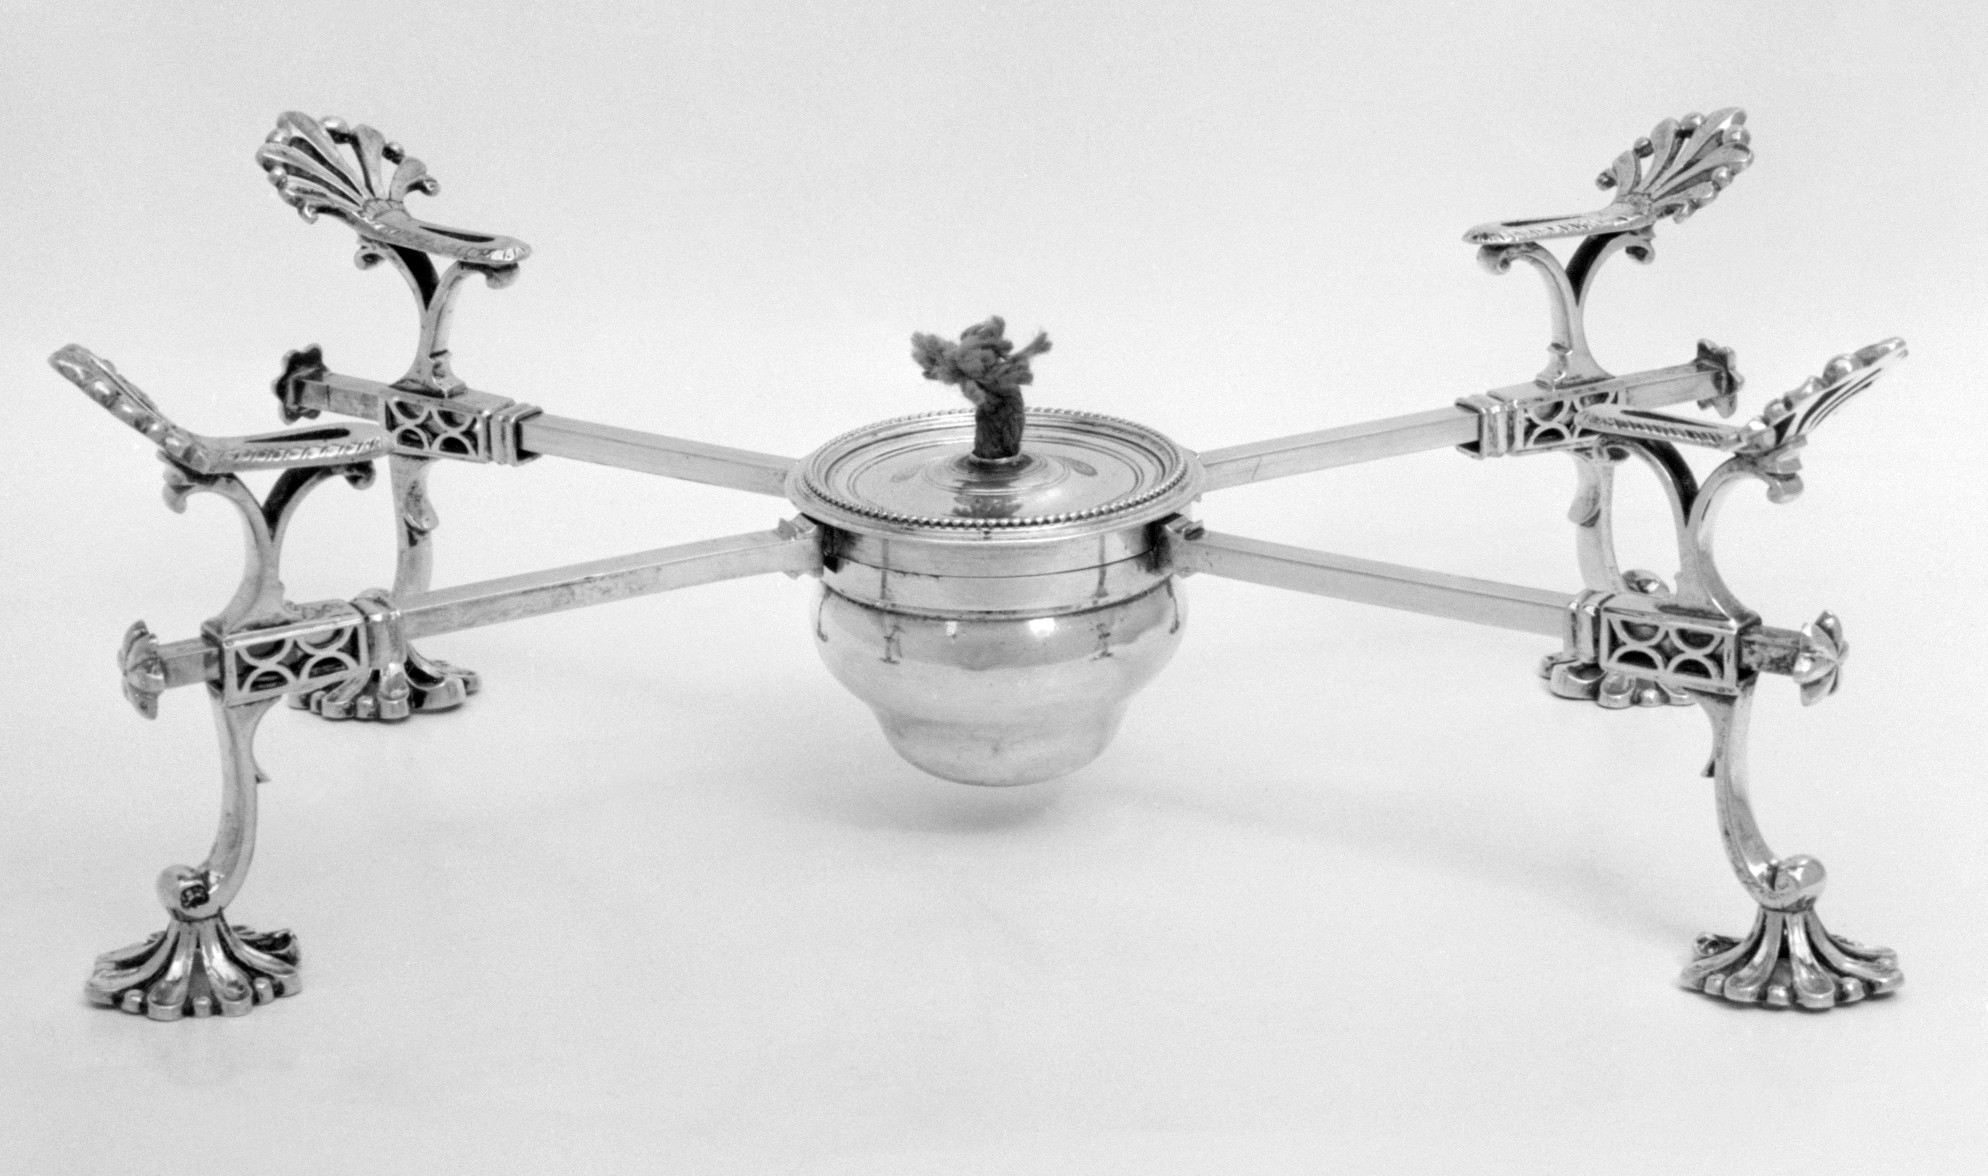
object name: dish cross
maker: william plummer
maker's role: maker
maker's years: 1755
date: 1773-1774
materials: silver